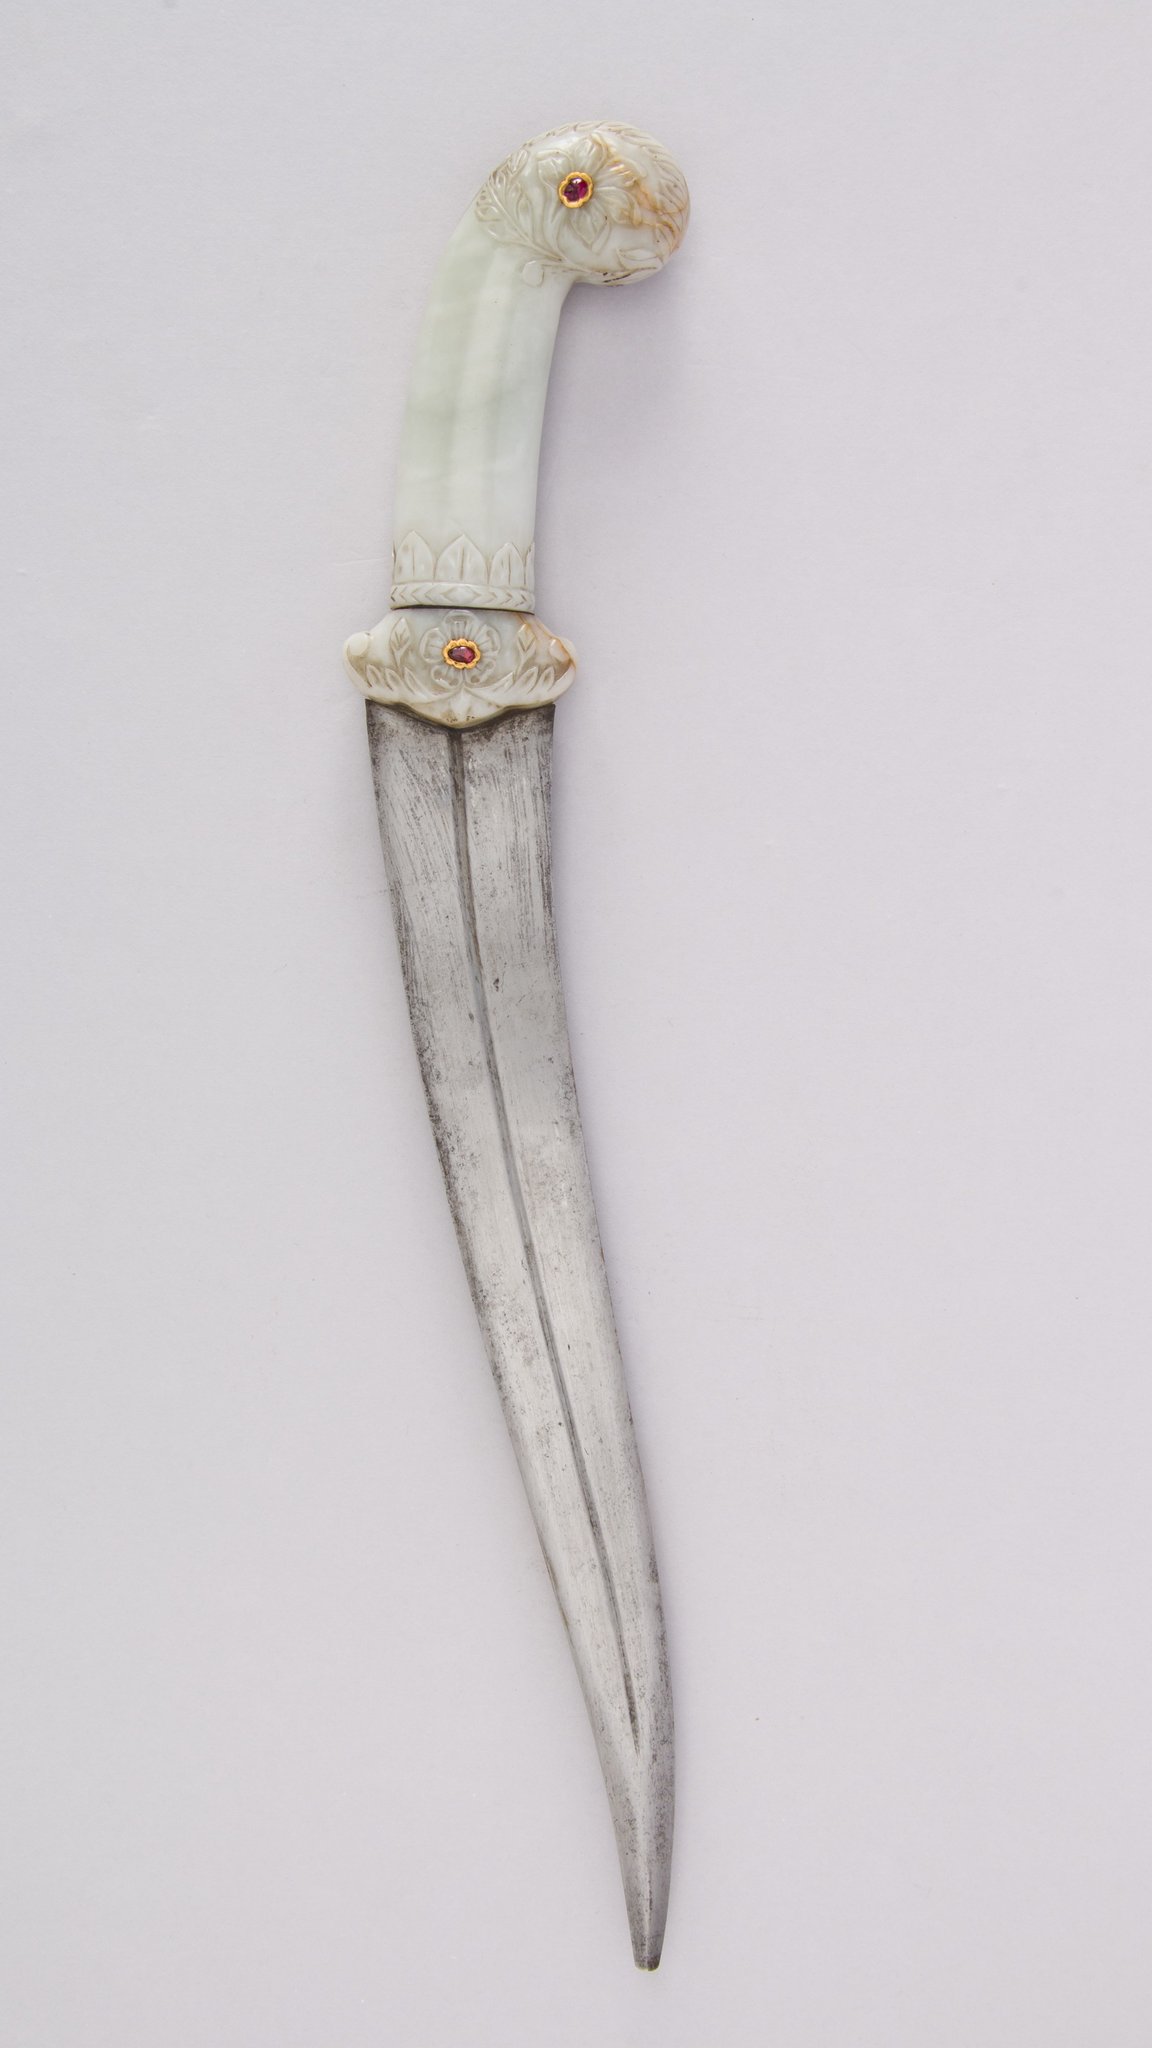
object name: dagger khanjar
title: Dagger (Khanjar)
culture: indian, mughal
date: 1801-1900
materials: gold, jade, gemstone, steel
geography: india